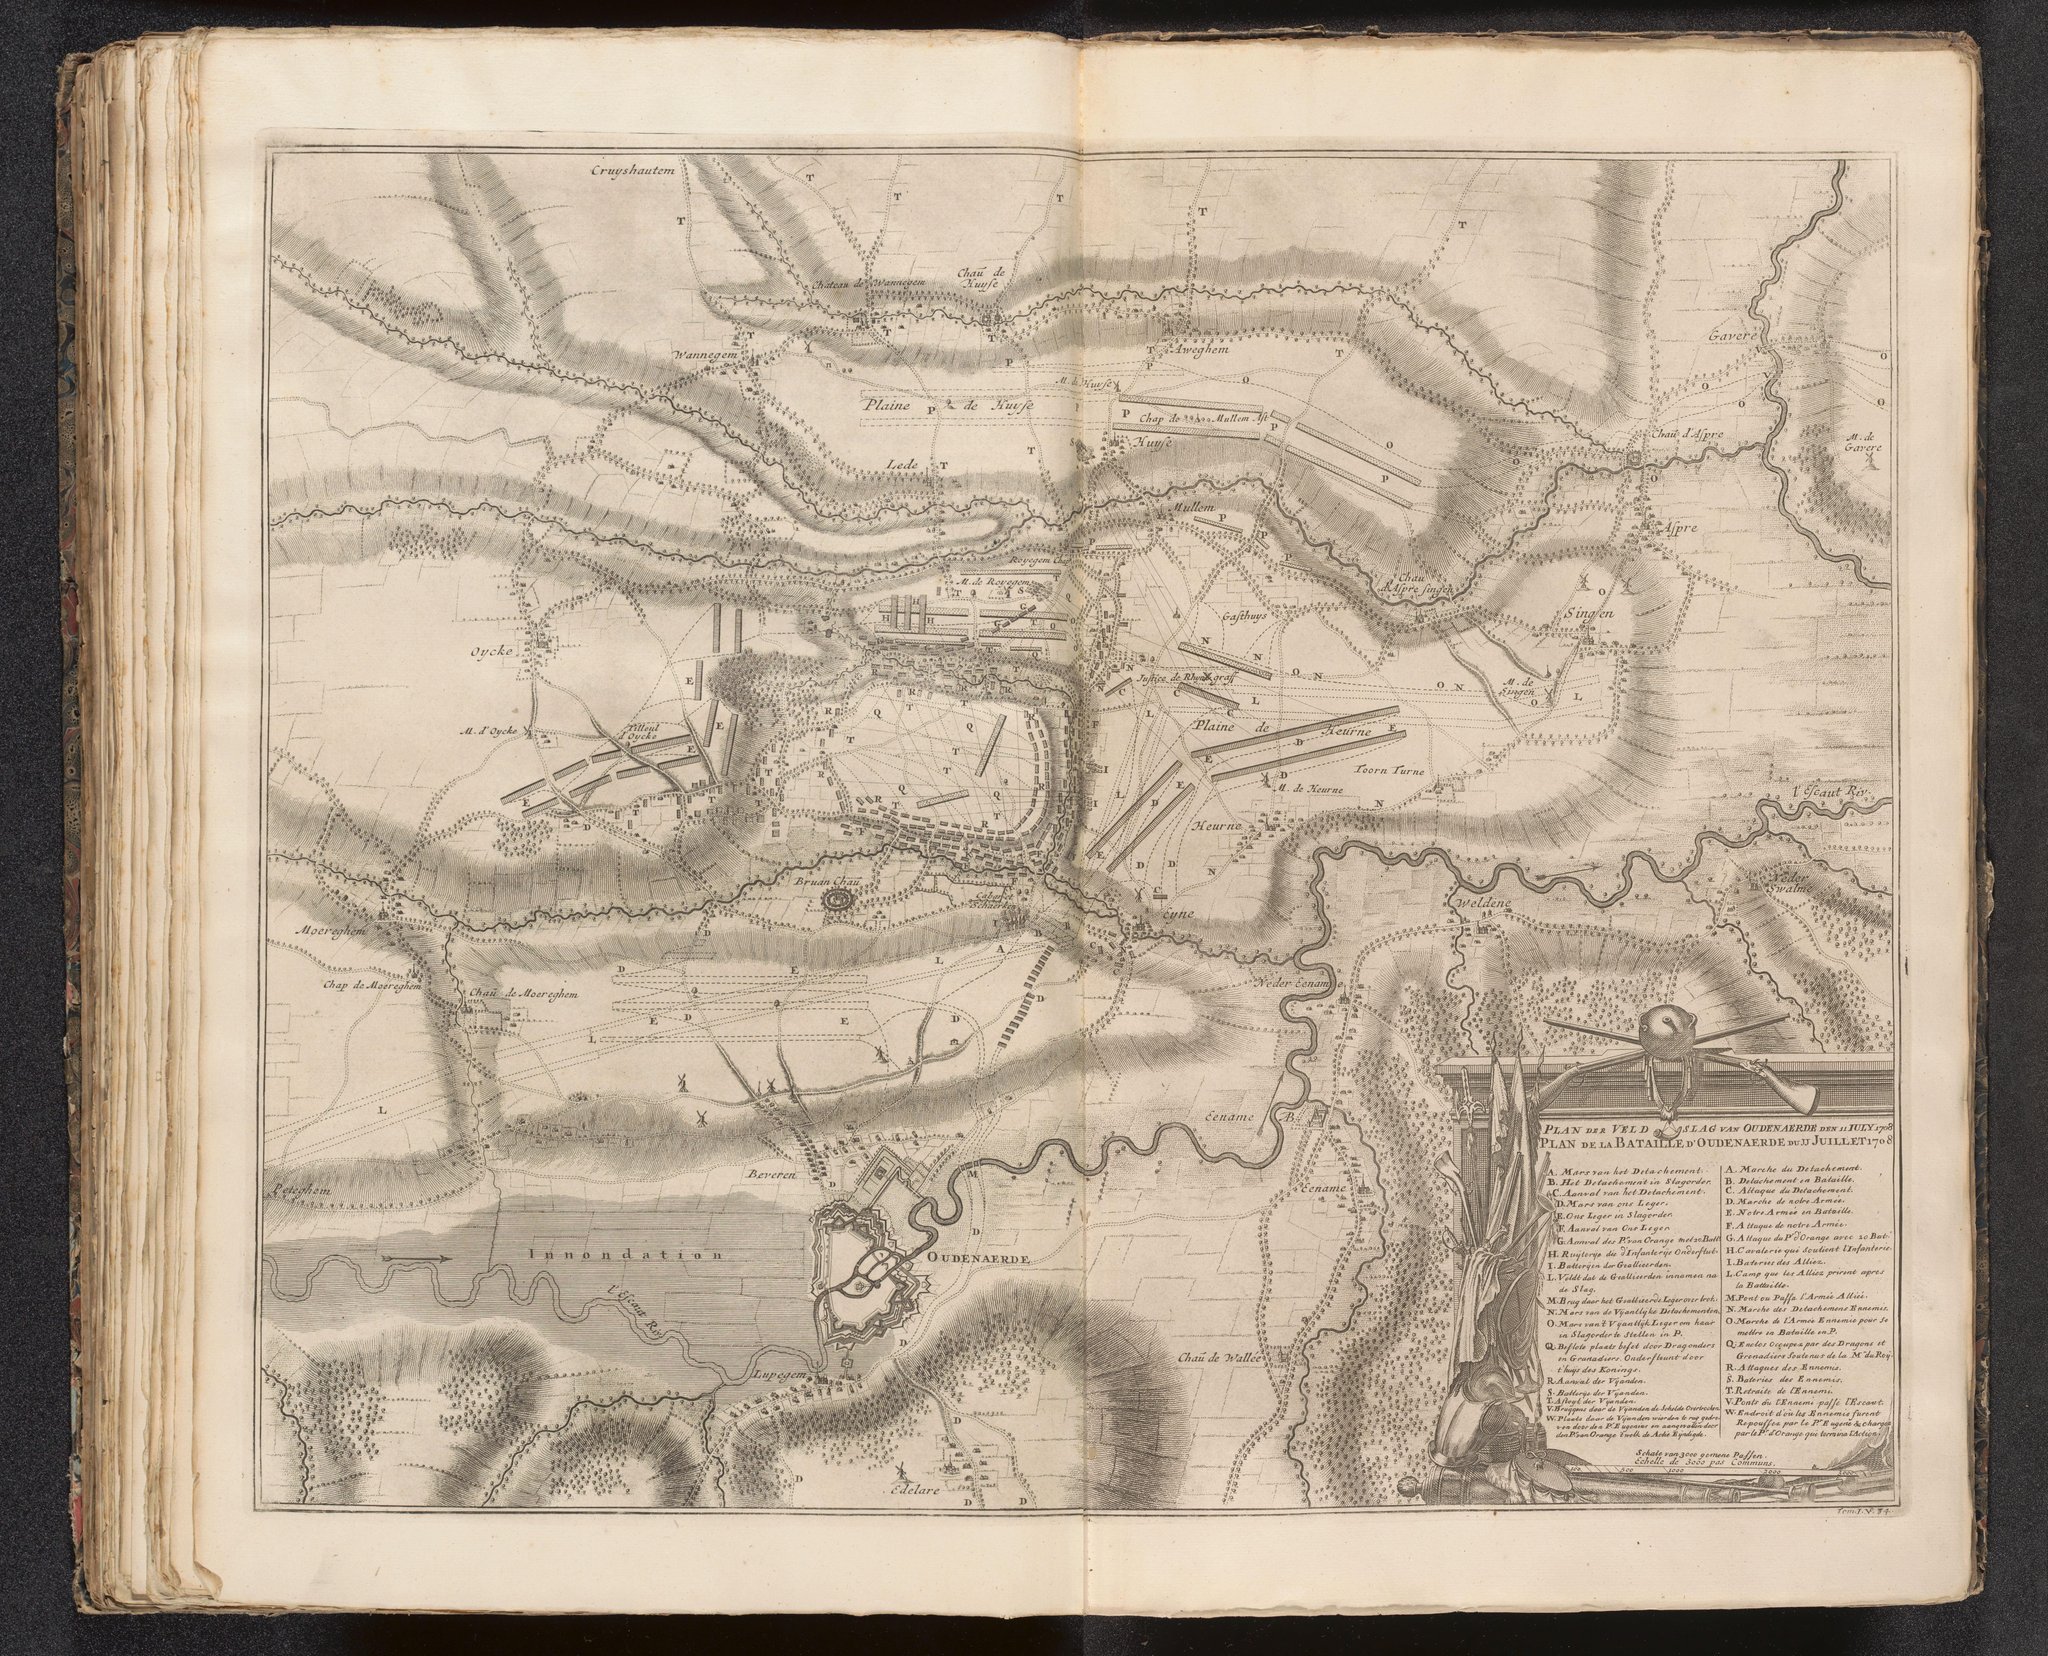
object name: map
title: Kaart van de slag bij Oudenaarde, 1708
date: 1708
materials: paper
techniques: engraving, etching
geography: northern netherlands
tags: johan willem friso (prins van oranje-nassau), john churchill (1e hertog van marlborough), maps of separate countries or regions, battle (+ land forces)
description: Kaart van de slag bij Oudenaarde tussen de Geallieerden onder de prins van Savoye en de hertog van Marlborough en de Fransen, 11 juli 1708. Genummerd rechtsonder: Tom. I. No. 34. Illustratie in het tweede deel van : [Jean] du Mont, Oorlogskundige beschryving van de veldslagen en belegeringen, der drie ... wydvermaarde krygsoversten... den Prins Eugenius van Savoye, den ... Hertog van Marlborough, en den Prins van Oranje en Nassau-Vriesland, in de editie van 1729. Dit tweede deel is hoofdzakelijk gewijd aan de daden van de hertog van Marlborough en prins Johan Willem Friso.